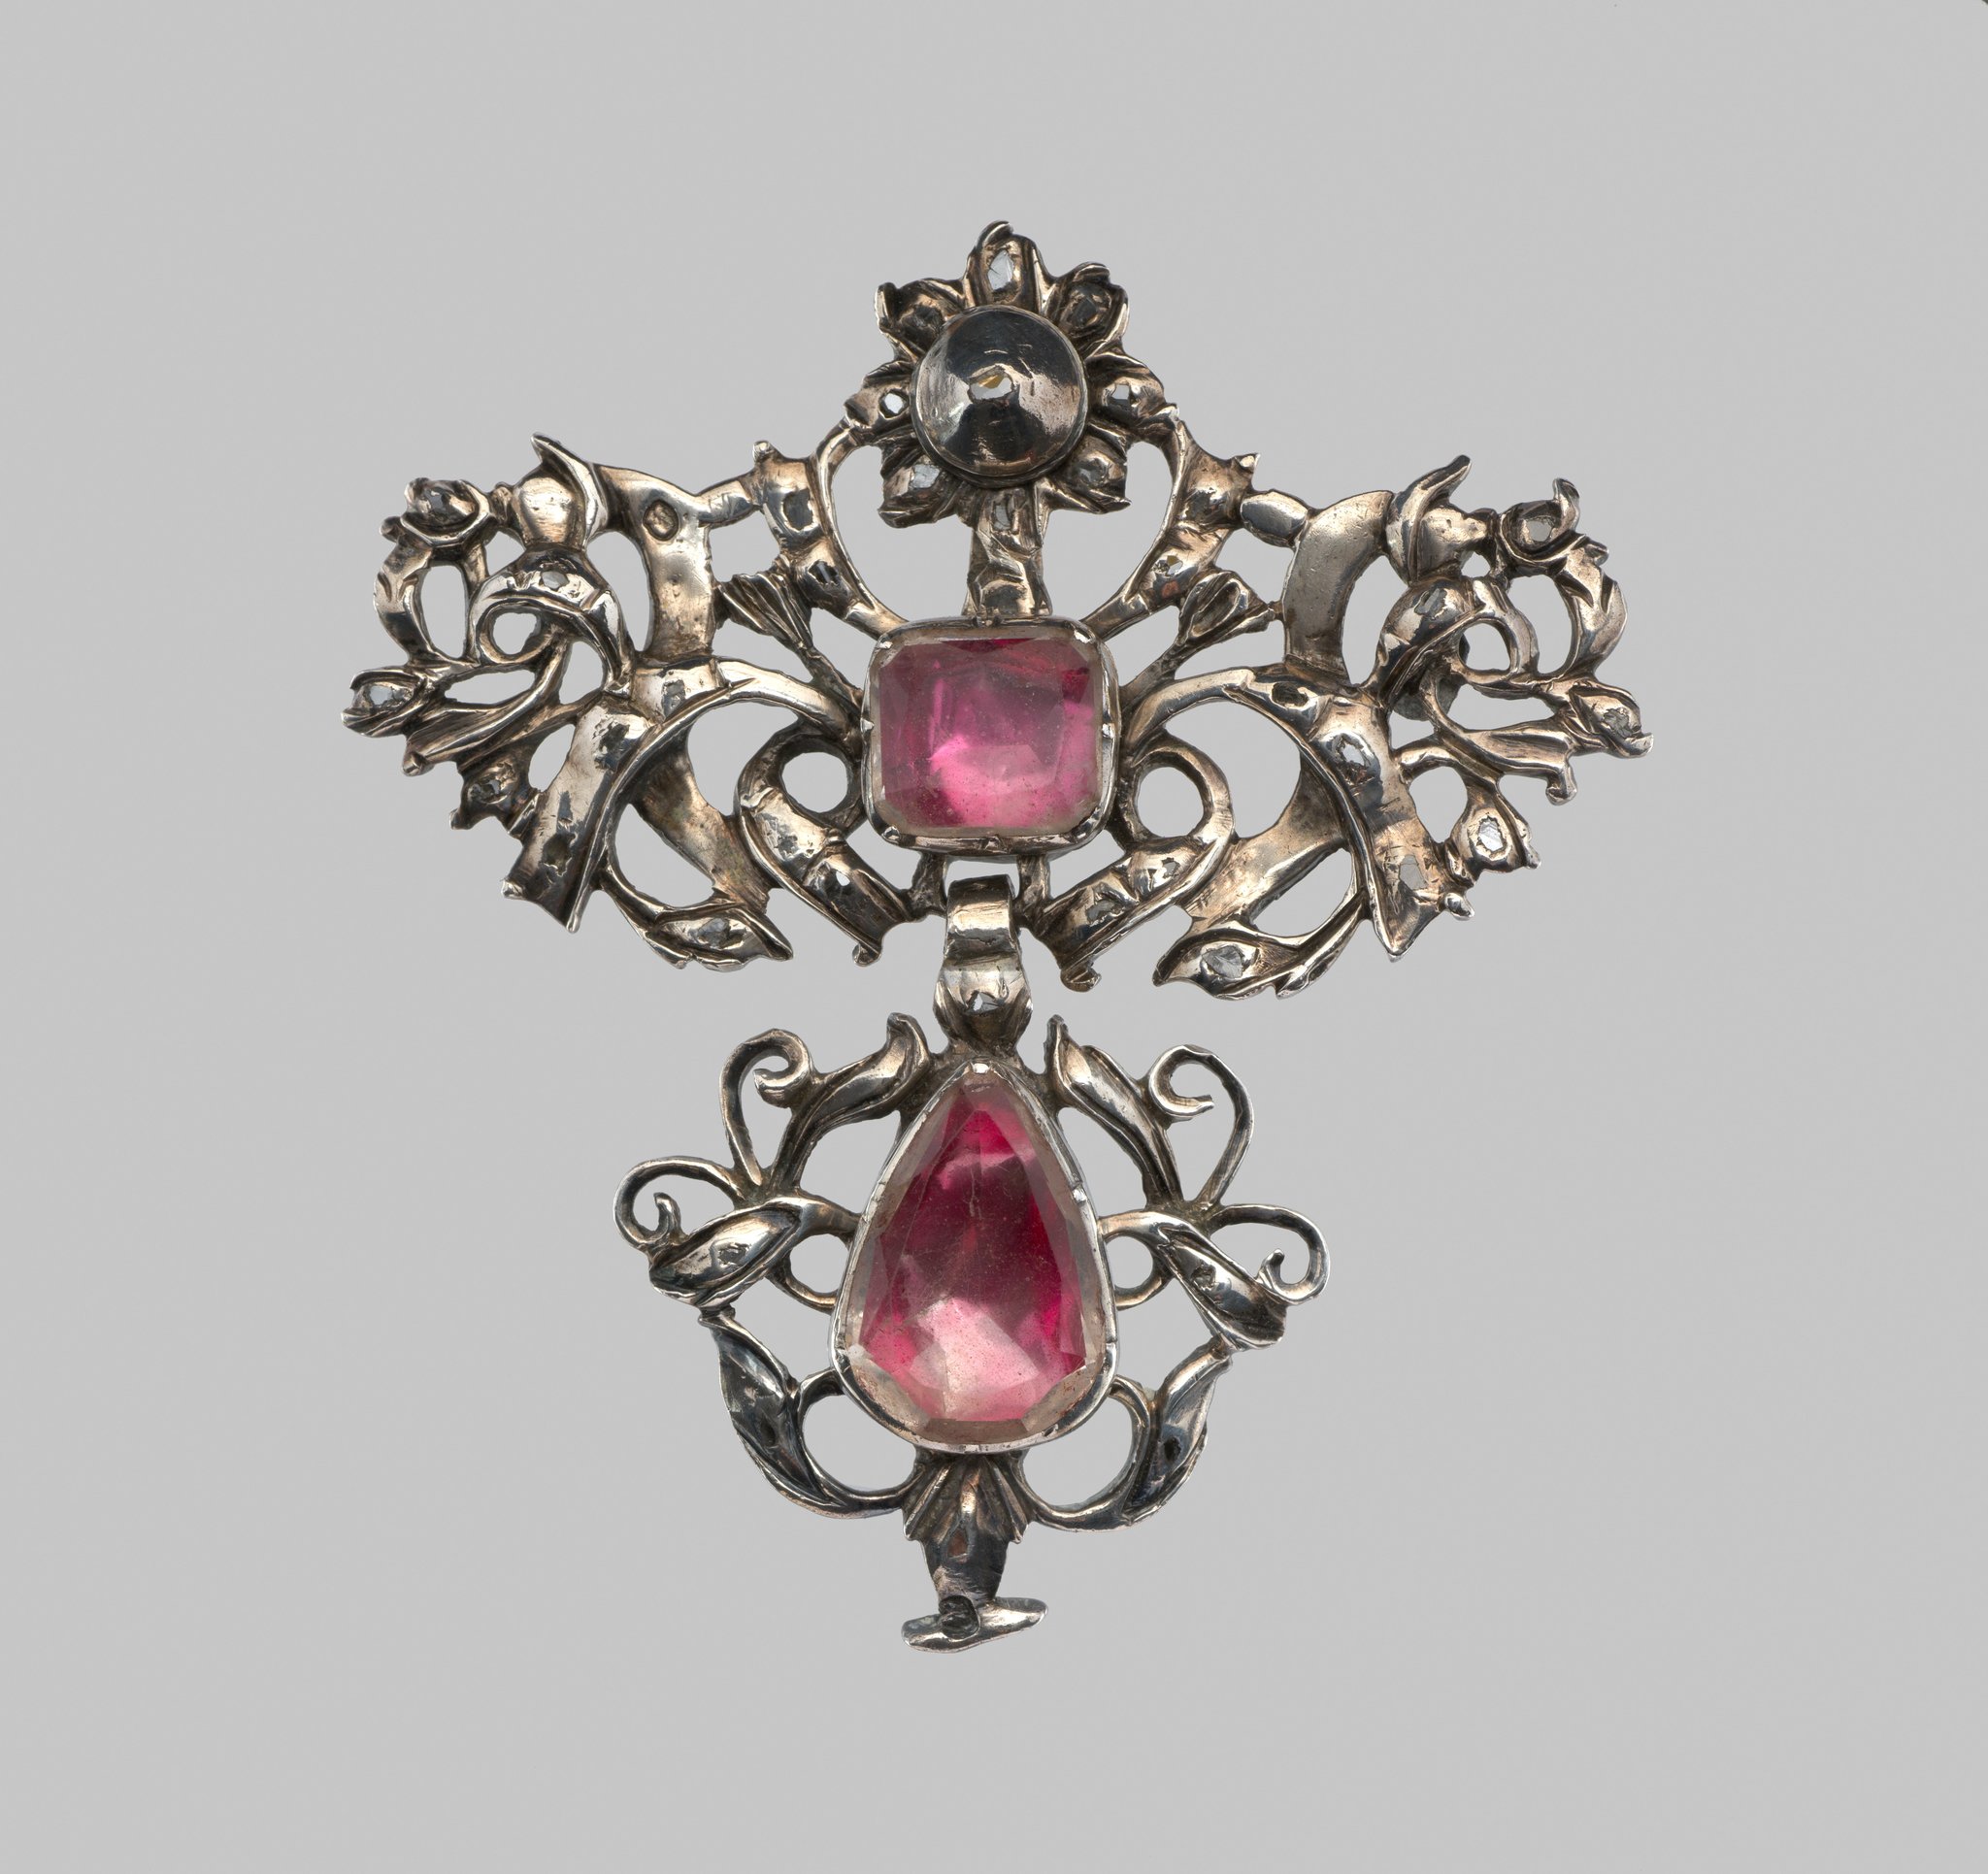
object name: brooch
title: Brooch (part of a set)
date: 1701-1800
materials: silver